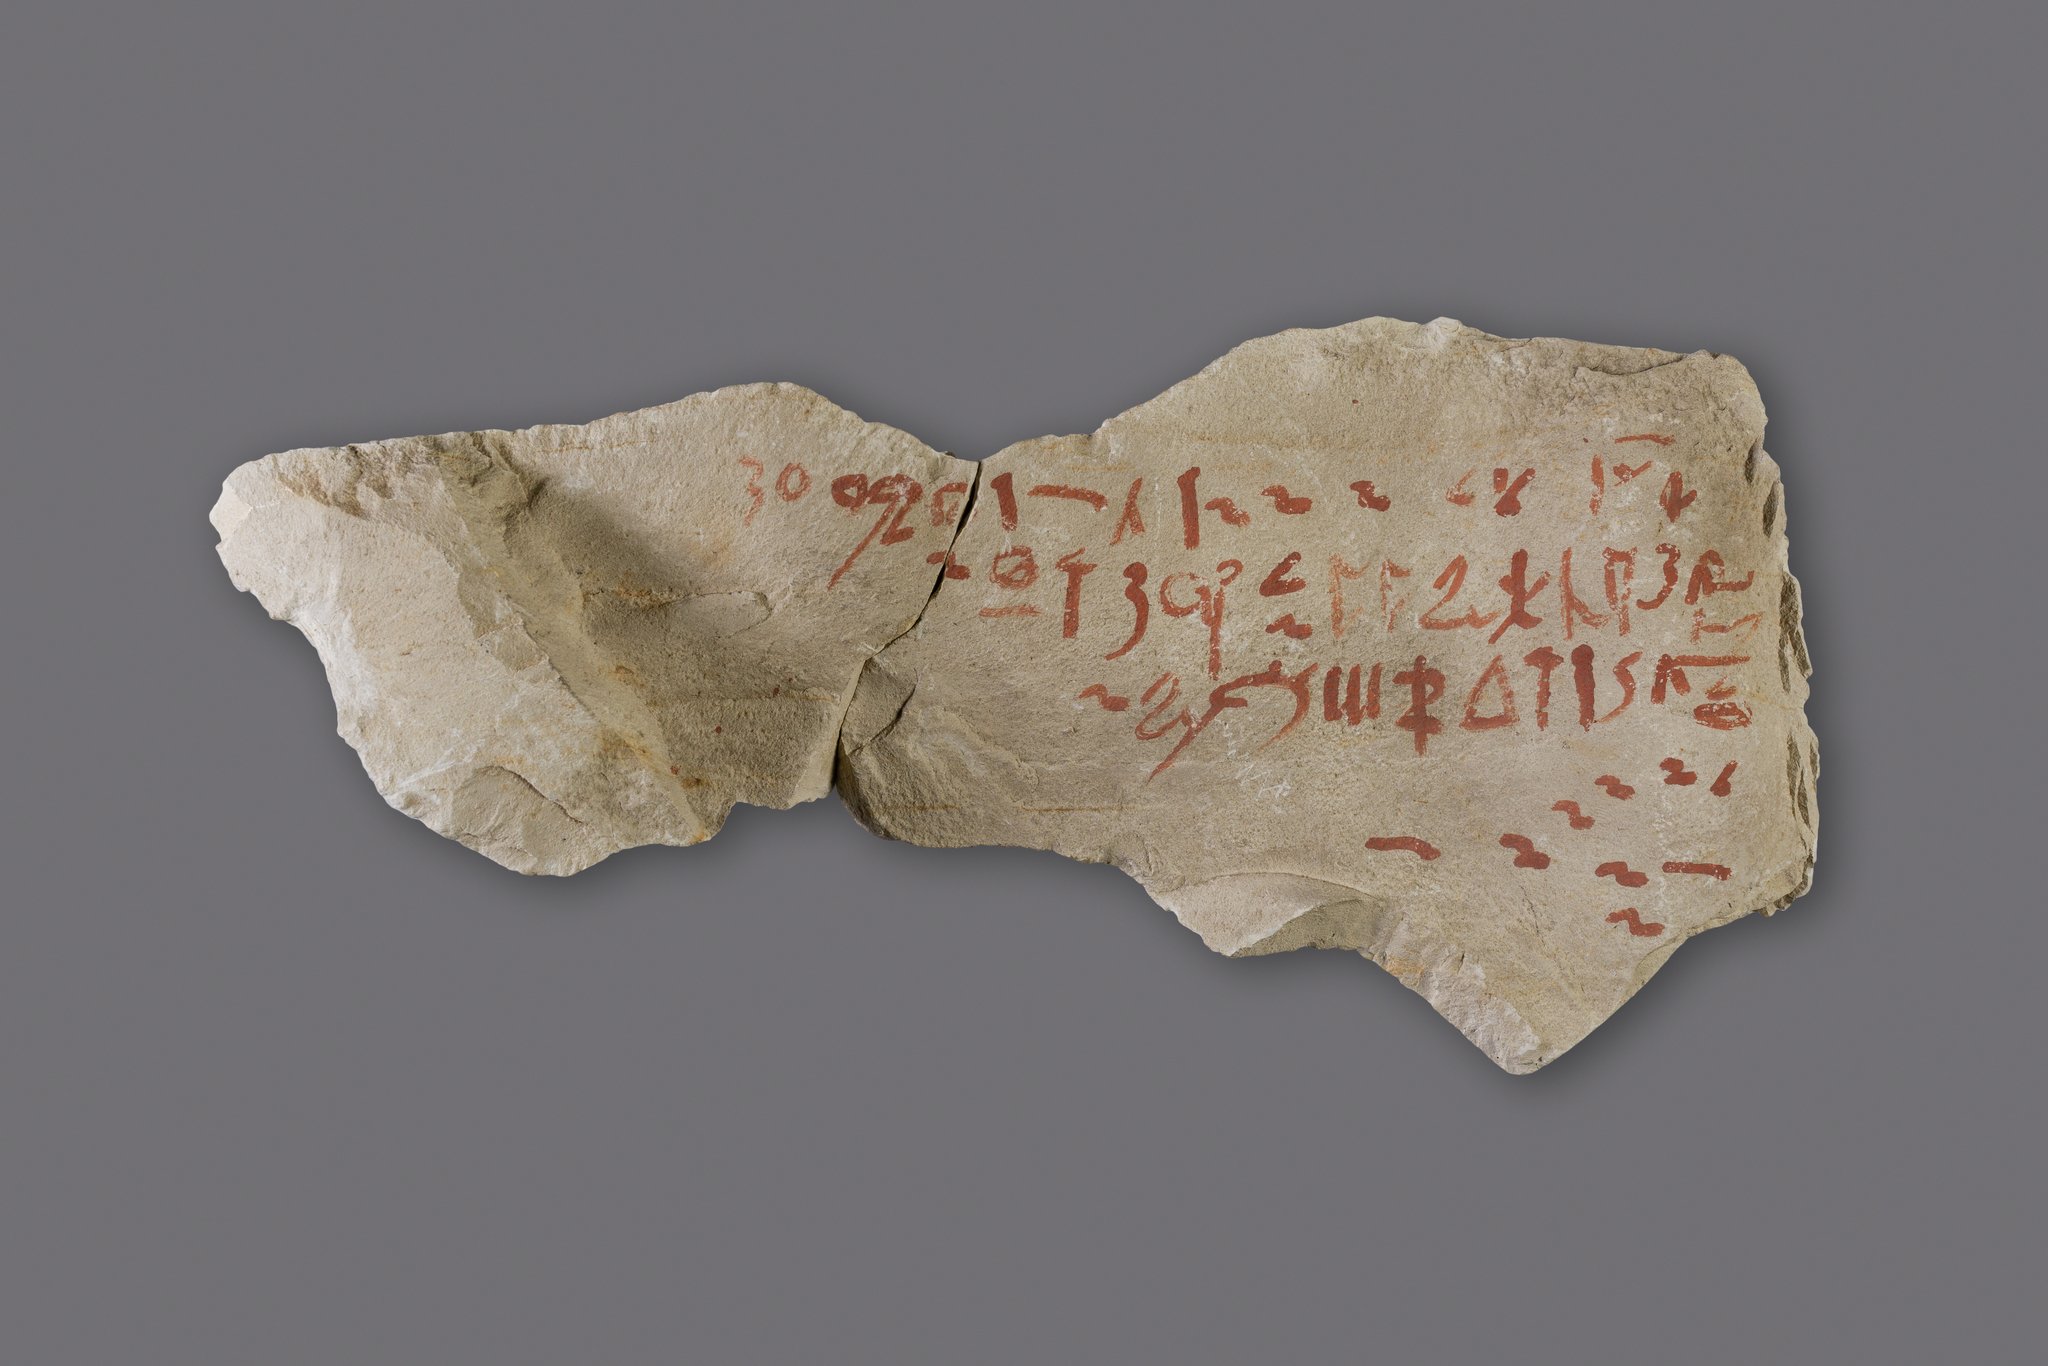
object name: ostracon, hieratic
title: Hieratic Ostracon with the beginning of "The Wisdom of Amenemope"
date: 525-404 BCE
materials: ink, limestone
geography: egypt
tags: hieratic